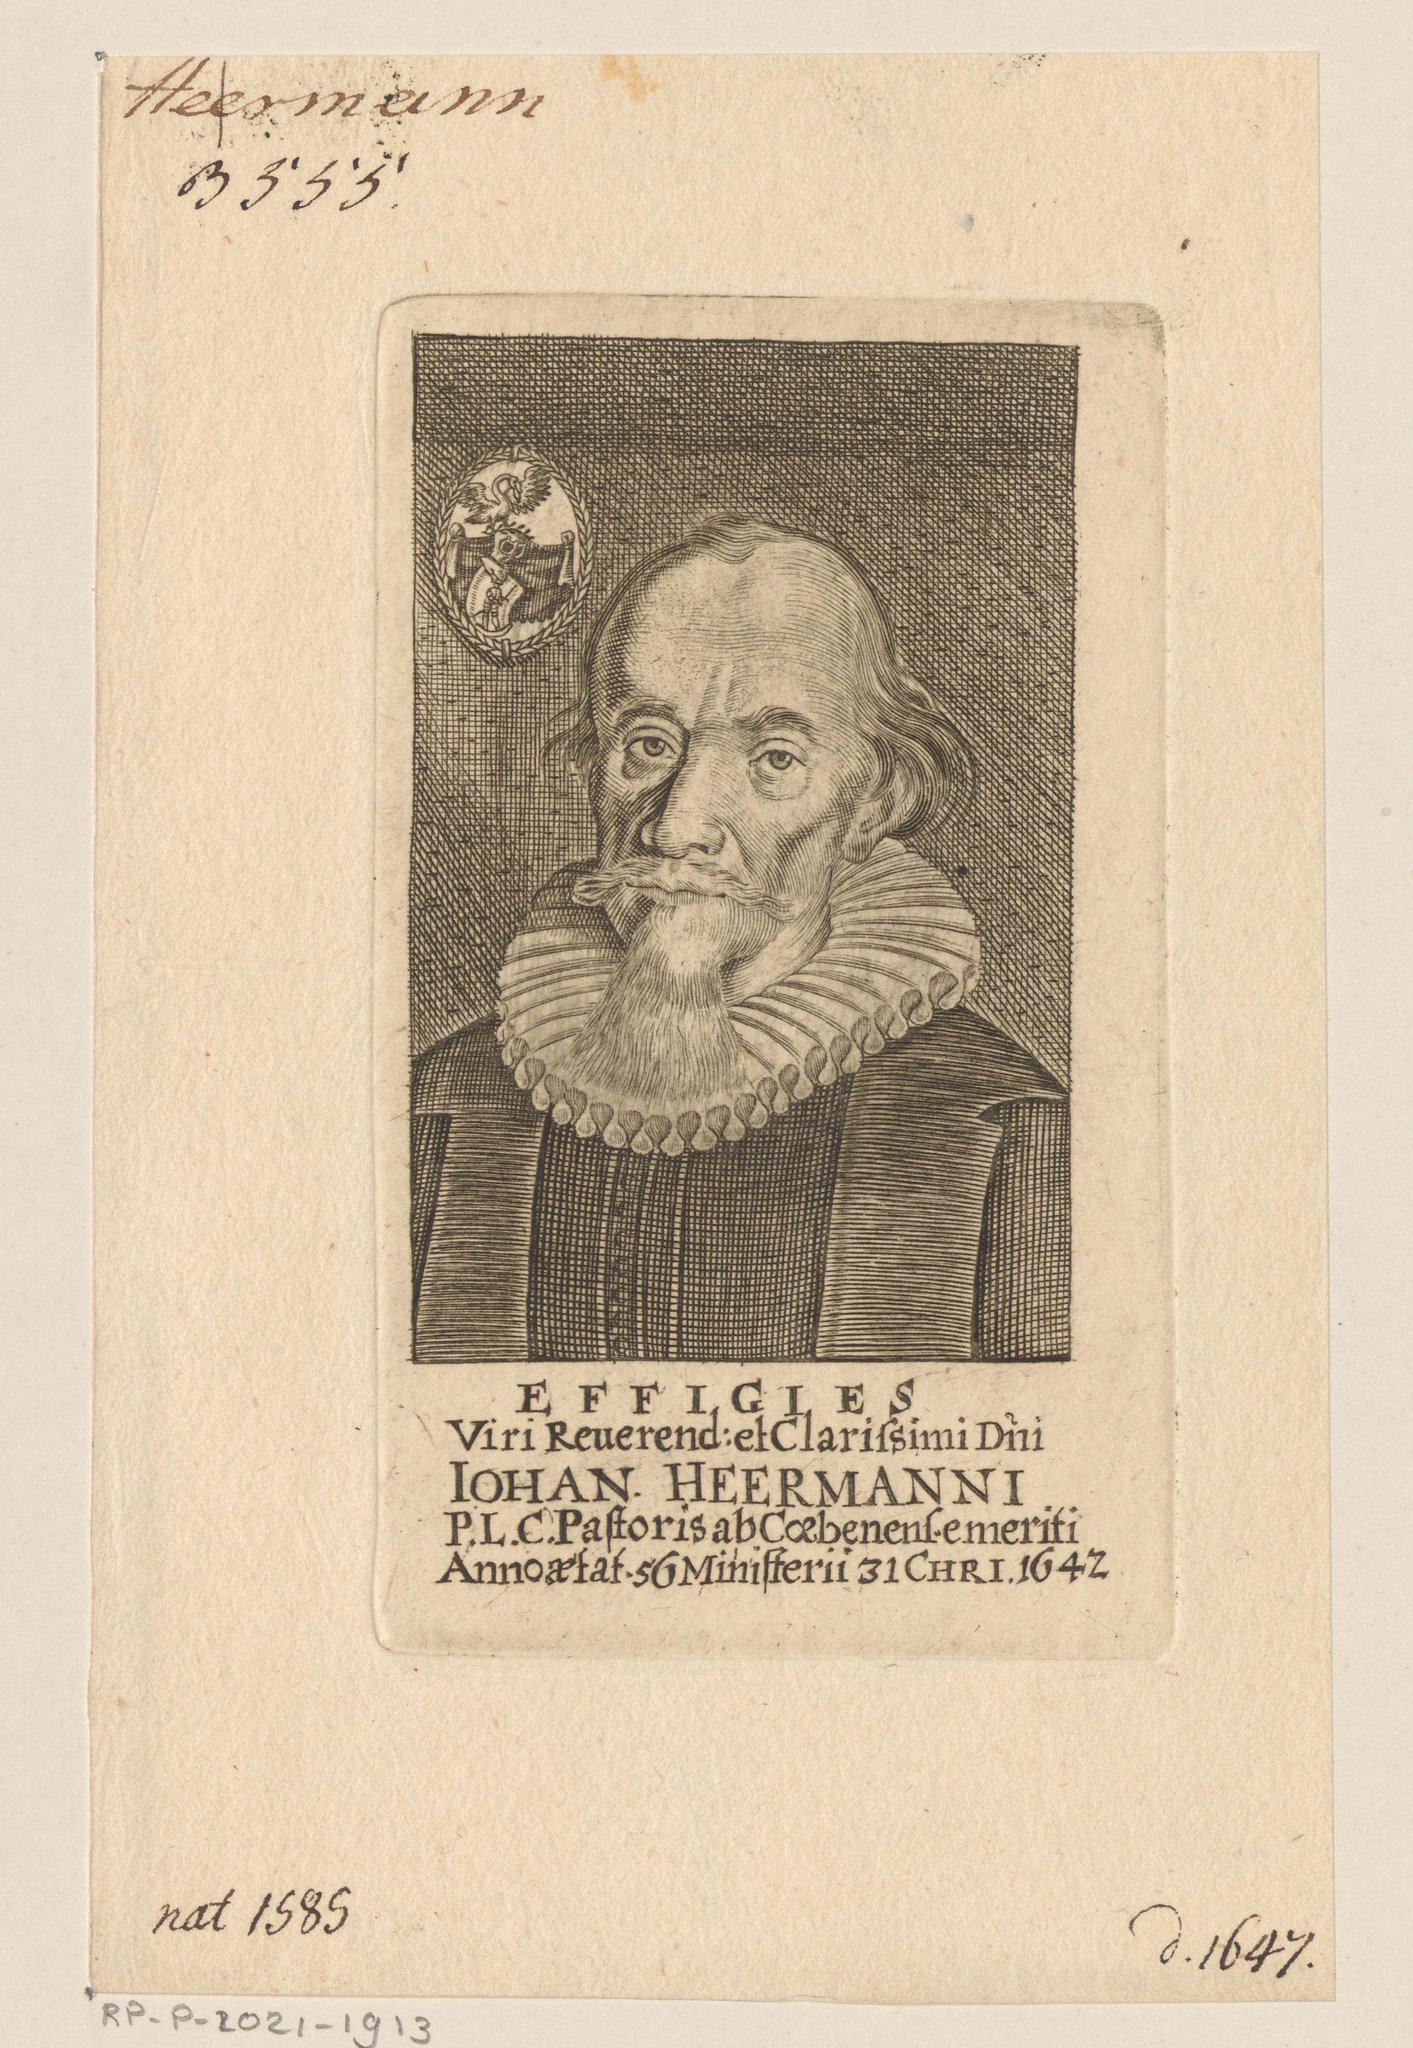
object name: print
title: Portret van Johann Heermann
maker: Anonymous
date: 1642-1699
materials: paper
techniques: engraving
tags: historical persons, armorial bearing, heraldry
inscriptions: inscription: ‘Heermann’, inscription: ‘B555’, inscription: ‘nat 1585 d. 1647.’